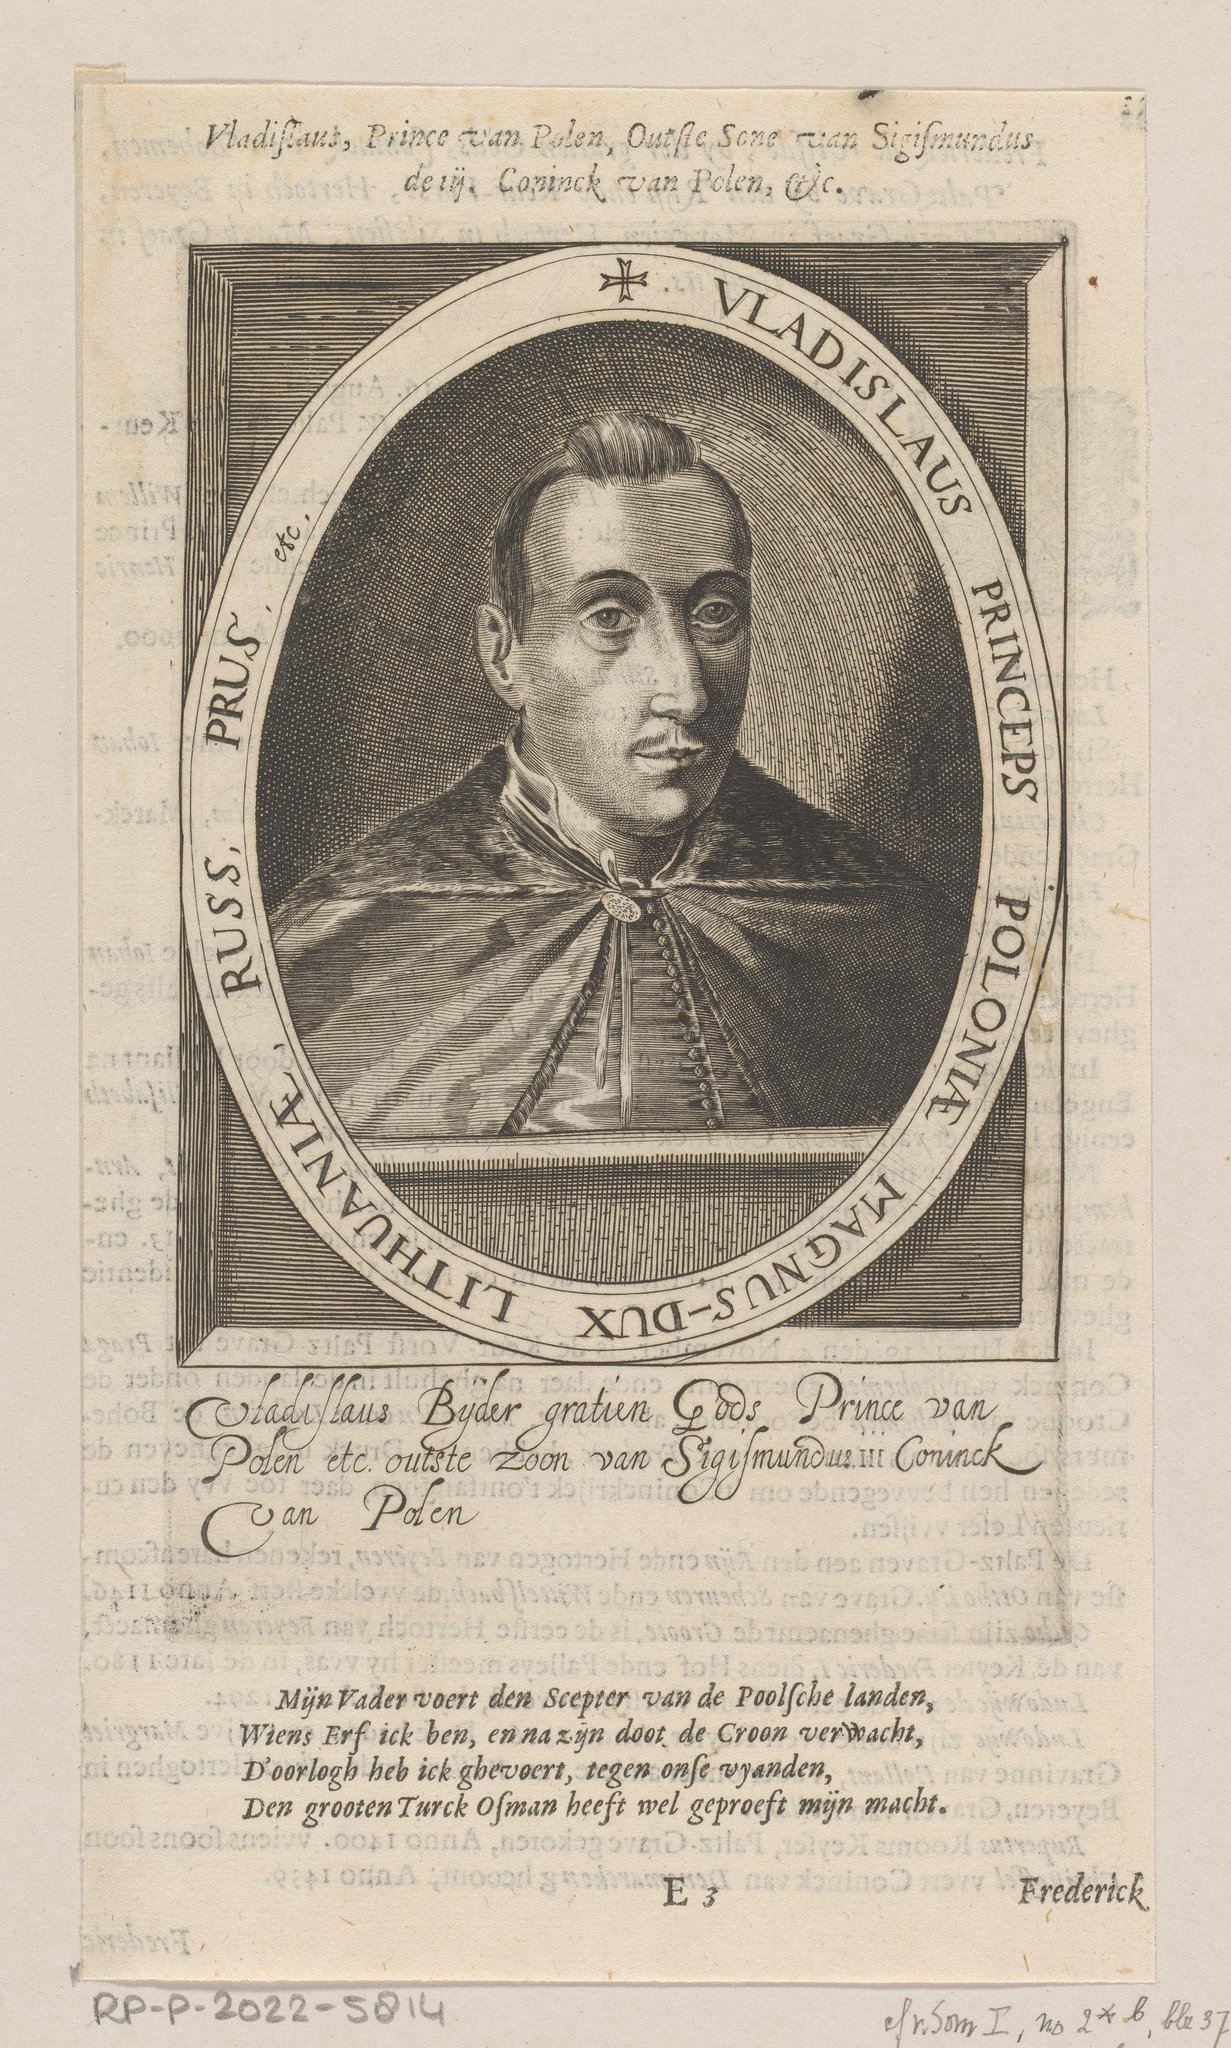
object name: print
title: Portret van Wladislaus IV van Polen als kroonprins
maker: Anonymous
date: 1625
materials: paper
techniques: engraving, letterpress printing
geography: delft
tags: wladislaus wasa (iv), historical persons, ruler, sovereign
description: Prent uit: Clerck, Nicolaes de. Princelyck Cabinet, Verthoonende T'leven Afcomste ende afbeeldingen der voornaemste Vorste (...). Delft: erven Nicolaes de Clerck, 1625. p. 37.